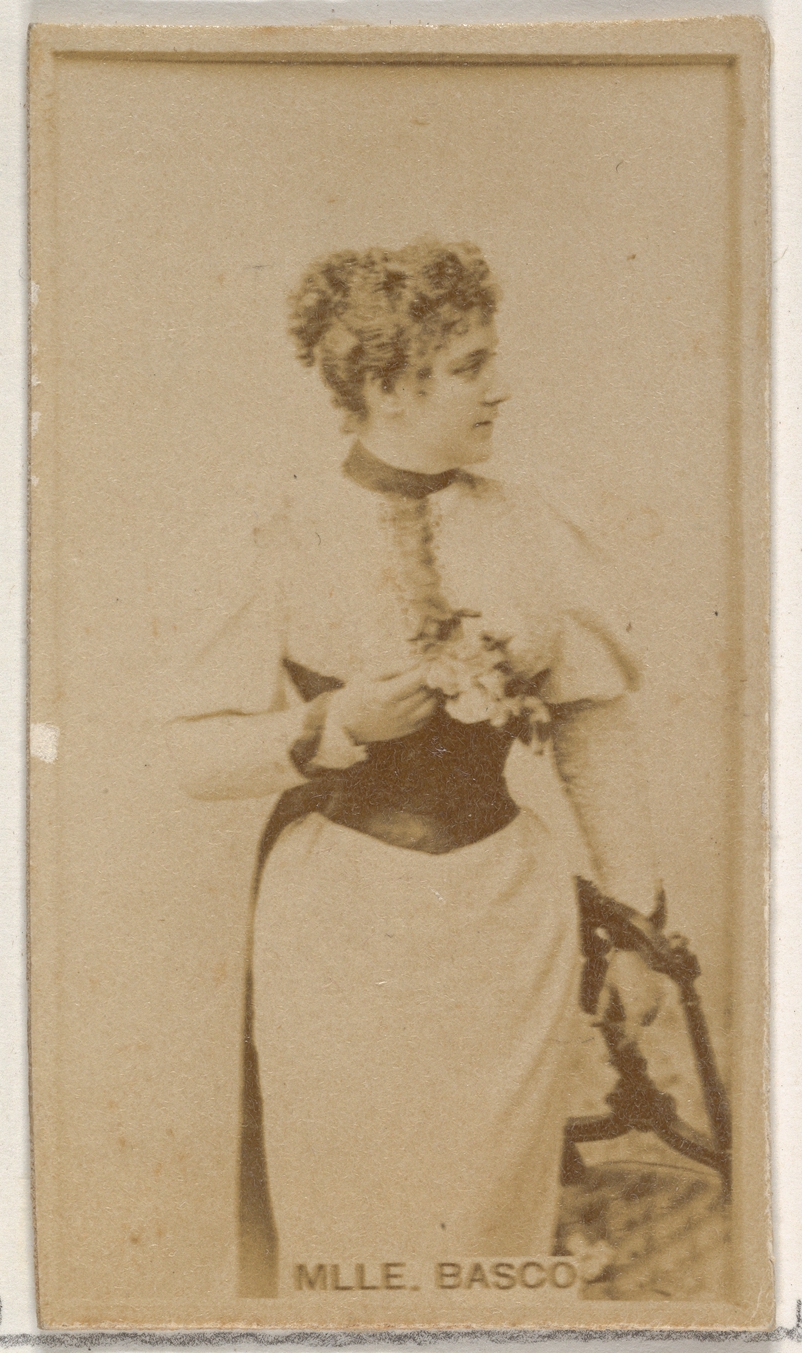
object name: photograph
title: Mlle. Basco, from the Actors and Actresses series (N45, Type 8) for Virginia Brights Cigarettes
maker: allen & ginter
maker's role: publisher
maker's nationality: american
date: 1888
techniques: albumen silver print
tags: portraits,women,actresses